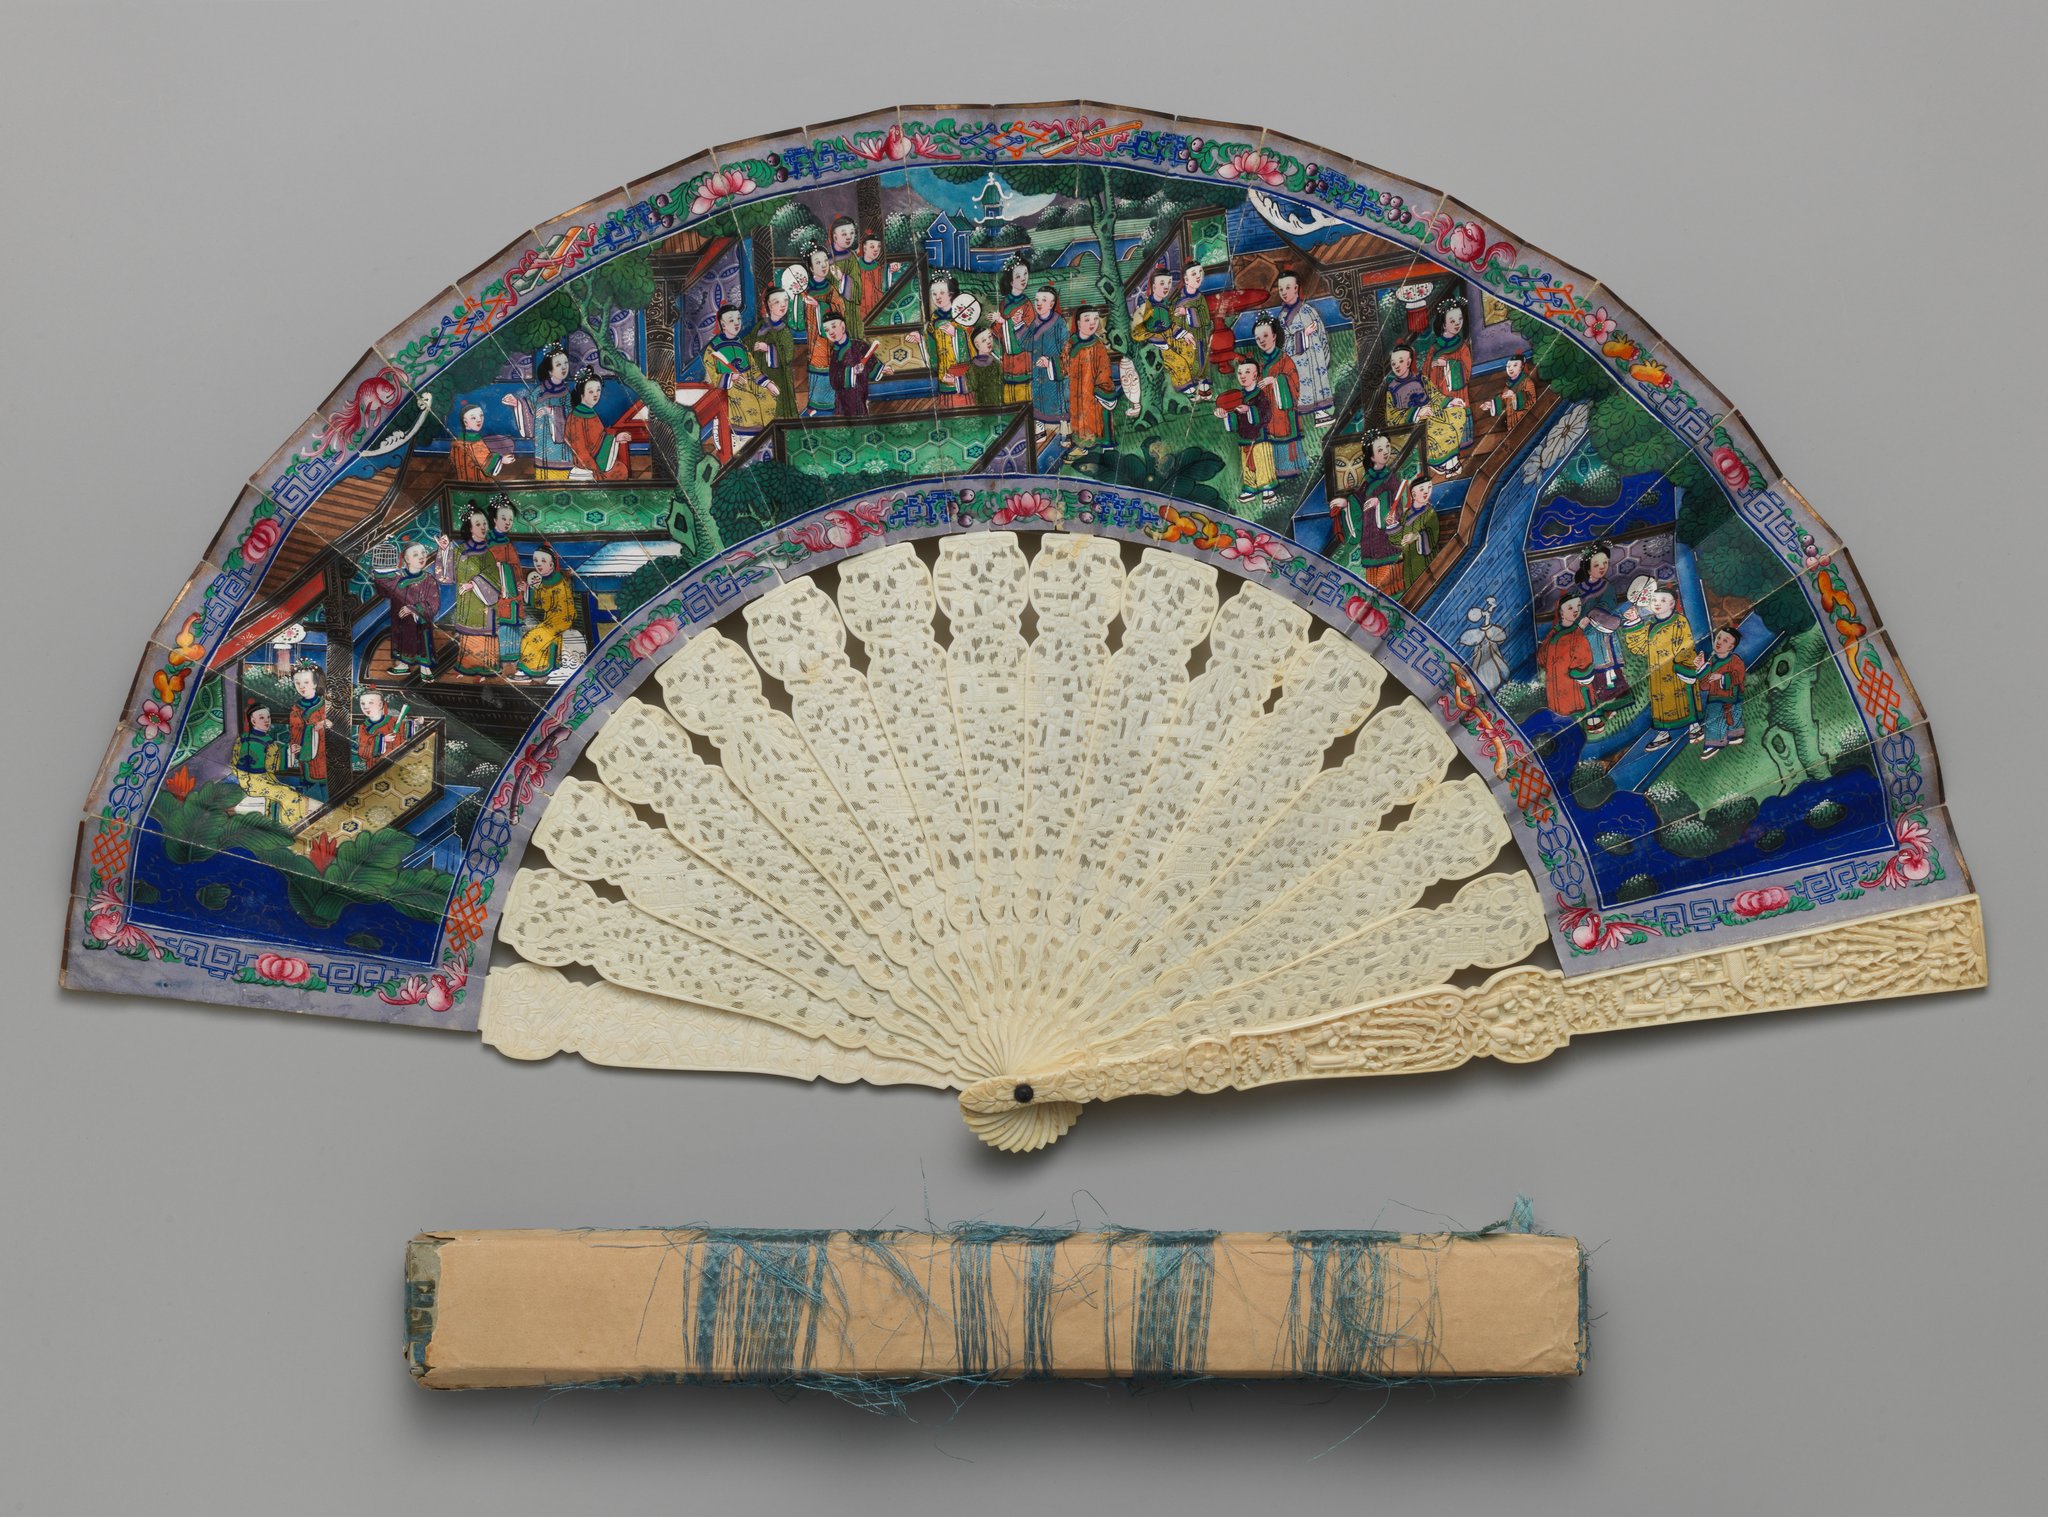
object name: fan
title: Folding Fan with Scene of Figures in a Courtyard Garden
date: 1767-1833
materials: ivory, paper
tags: men,women